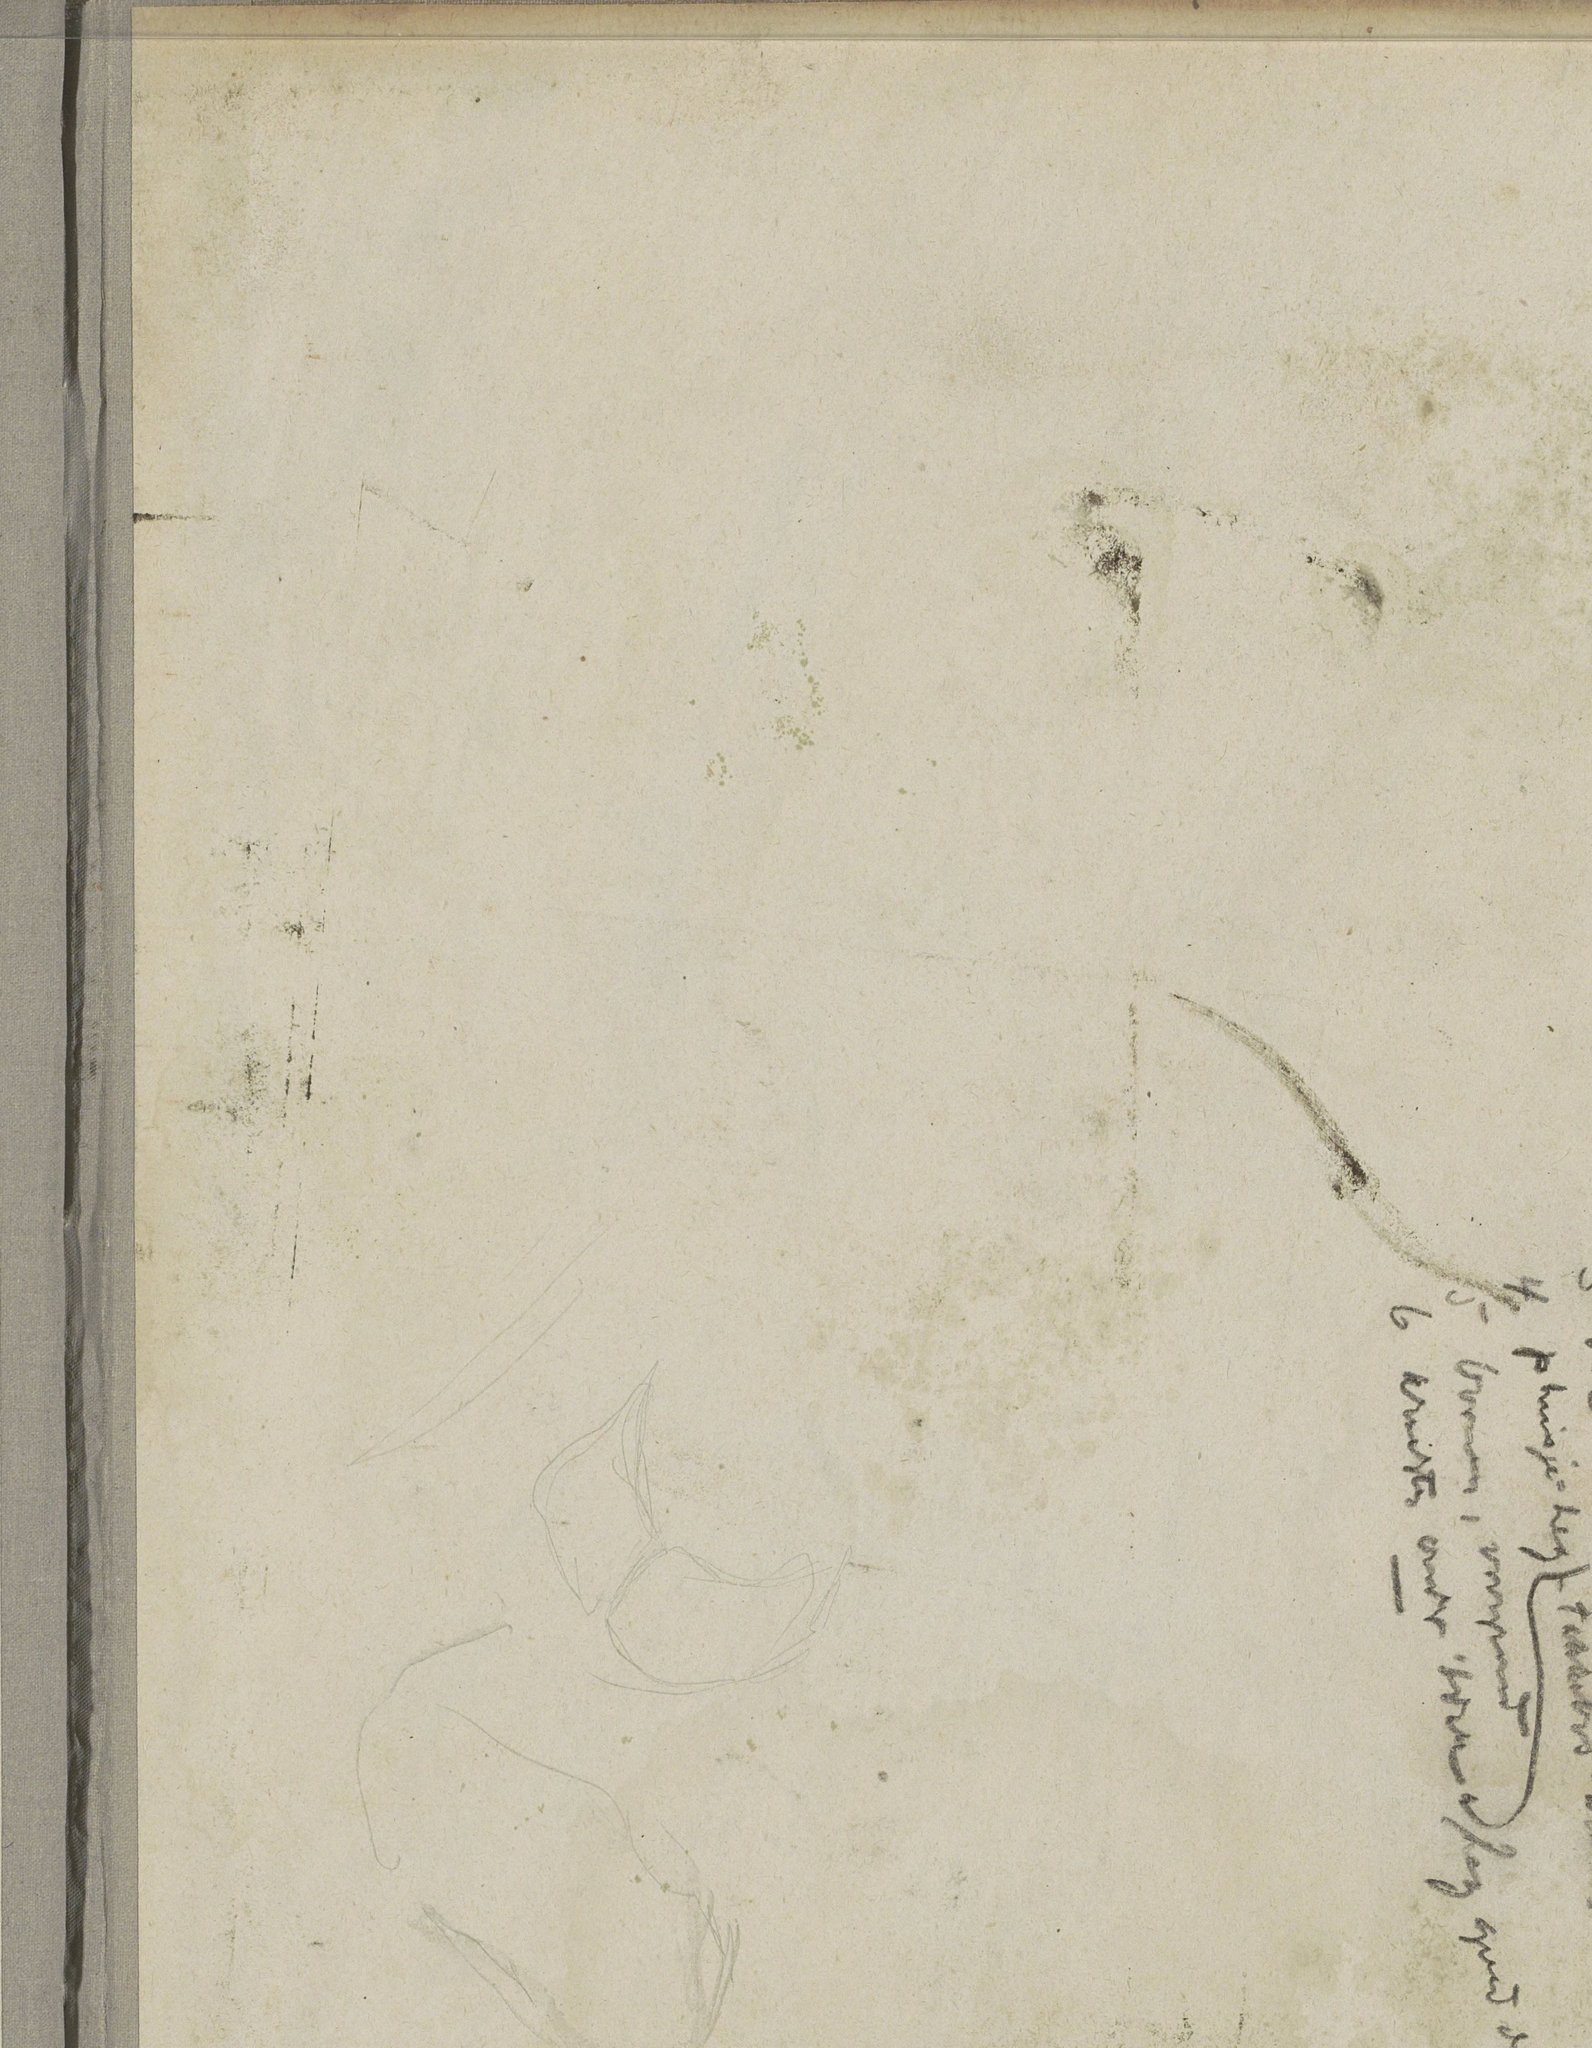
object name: endleaf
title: Studies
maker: willem witsen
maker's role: draughtsman, painter, print maker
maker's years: 1860-1923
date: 1874-1923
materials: paper, pencil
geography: ewijkshoeve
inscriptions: annotation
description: Schutblad B, achterste schutblad, uit een schetsboek met 72 bladen.